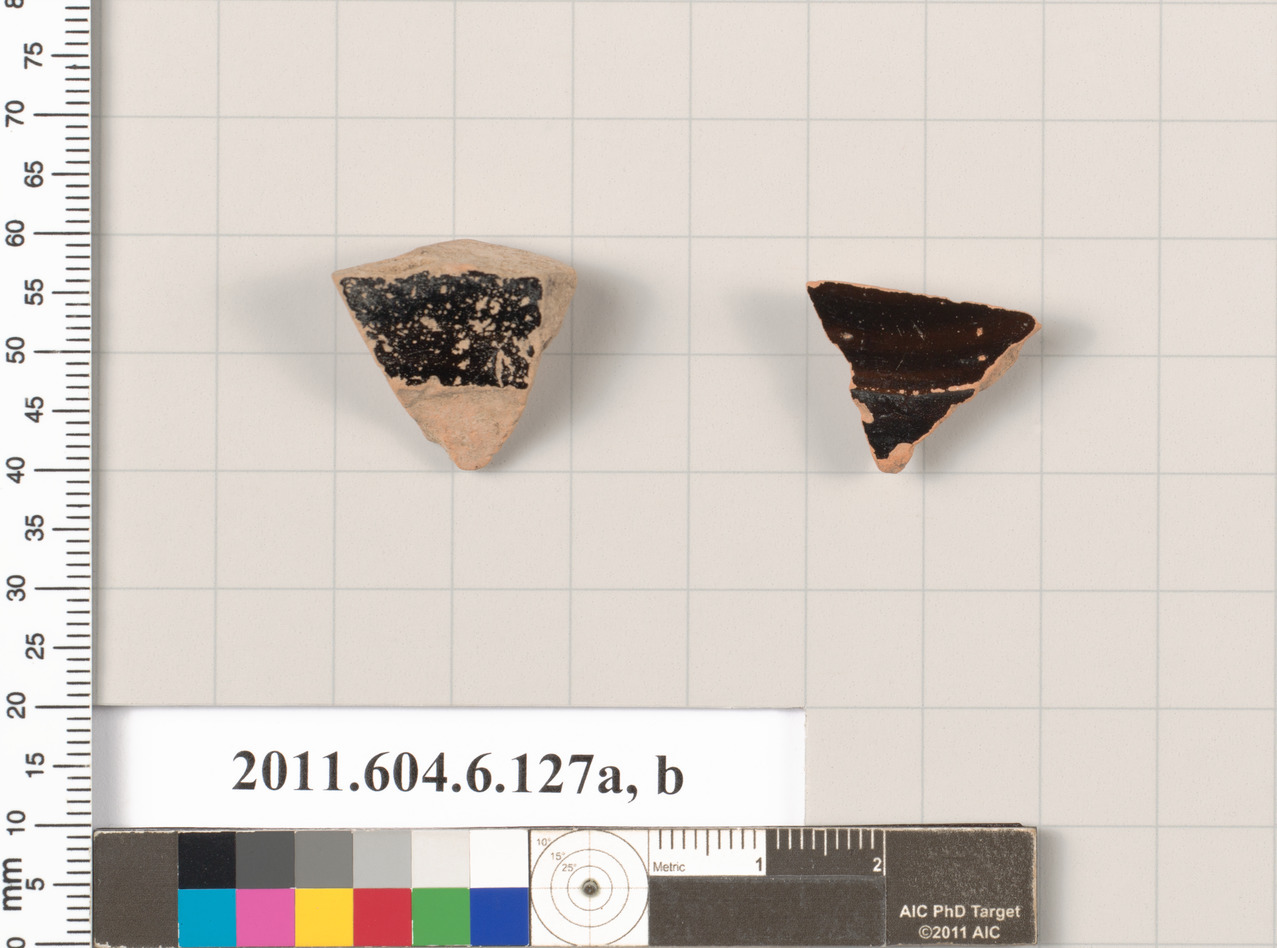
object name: undetermined closed shape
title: Terracotta fragments of closed shapes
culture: greek, attic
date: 600-401 BCE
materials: terracotta